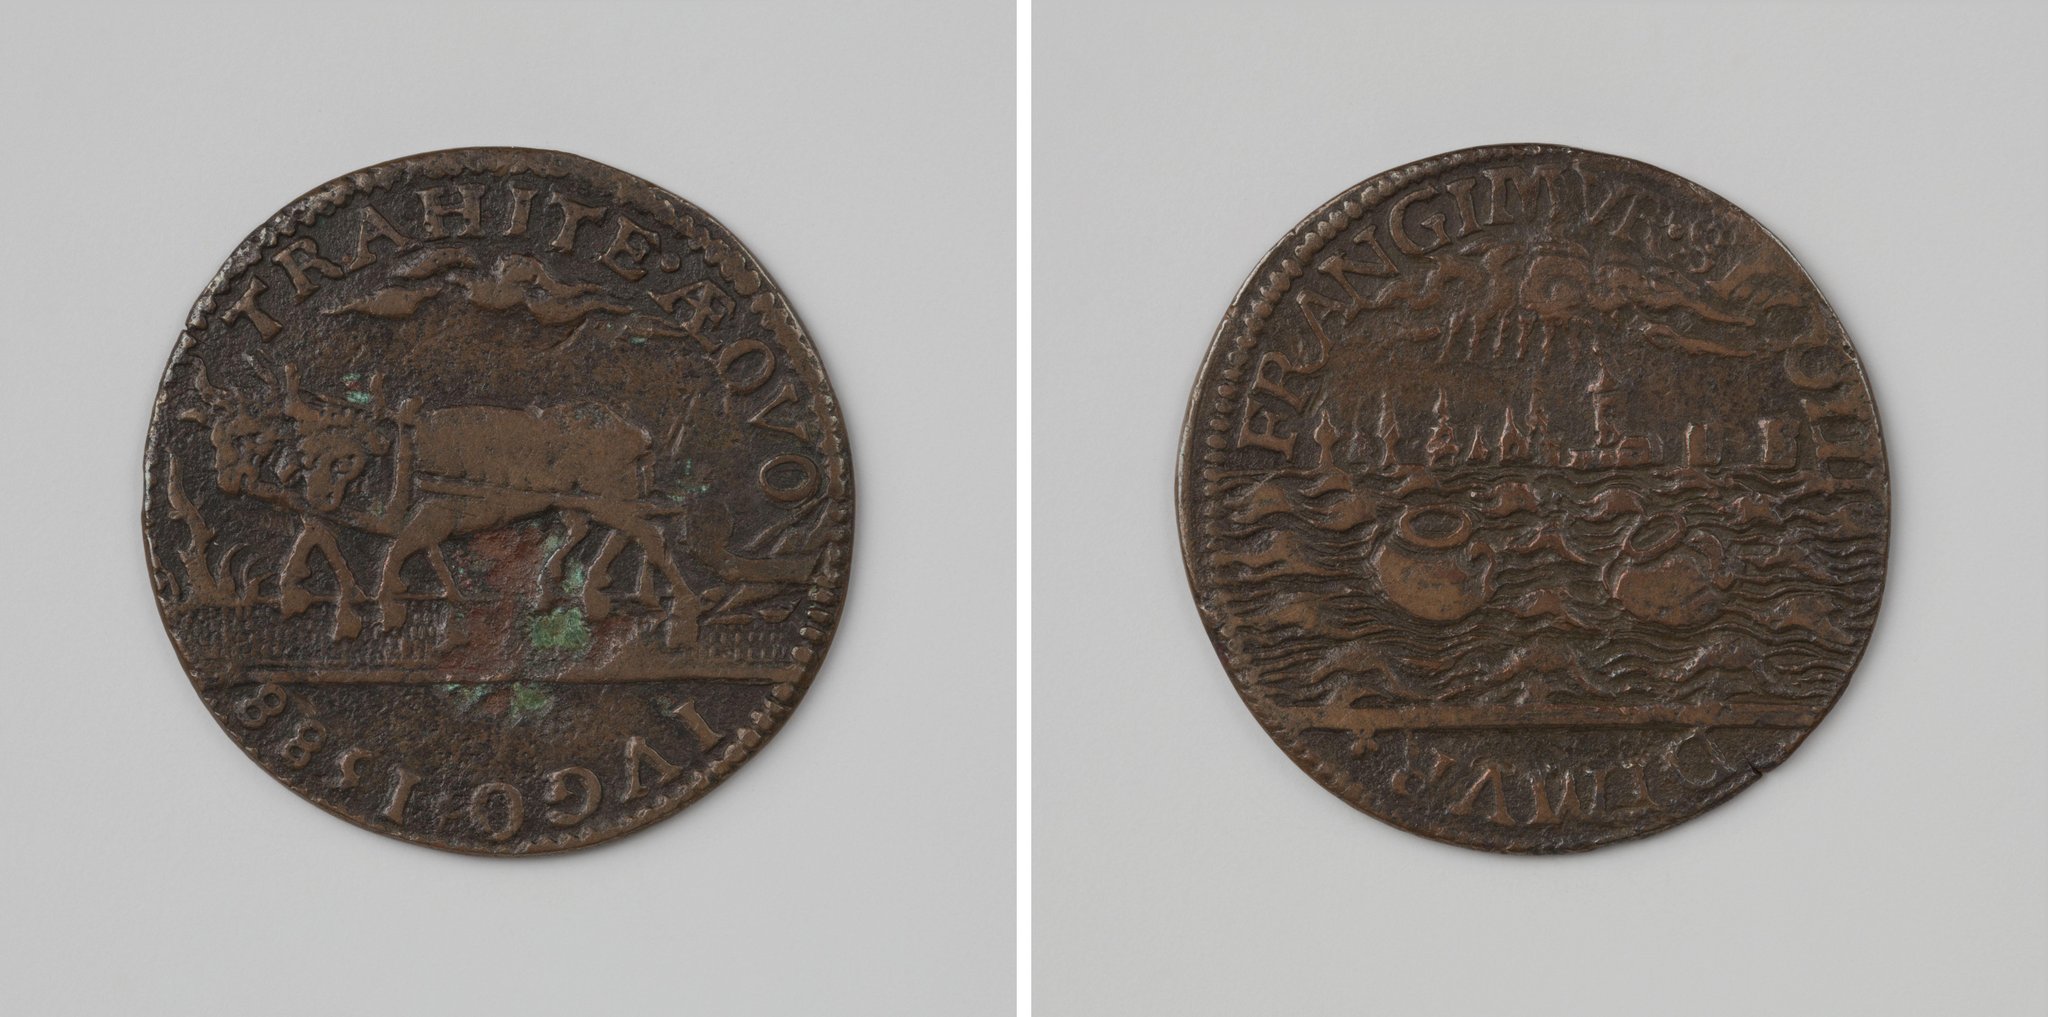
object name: jeton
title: Aansporing tot eendracht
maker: paulus van wtewael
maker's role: die cutter, draughtsman, print maker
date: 1588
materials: copper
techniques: striking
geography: hoorn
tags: tachtigjarige oorlog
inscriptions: circumscription: ‘TRAHITE AEQVO IVGO / 1588’, circumscription: ‘FRANGIMVR SI COLLIDIMVR’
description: Koperen penning. Voorzijde: span ossen voor ploeg binnen omschrift. Keerzijde: gezicht op stad Hoorn aan water, waarop twee potten drijven binnen omschrift.